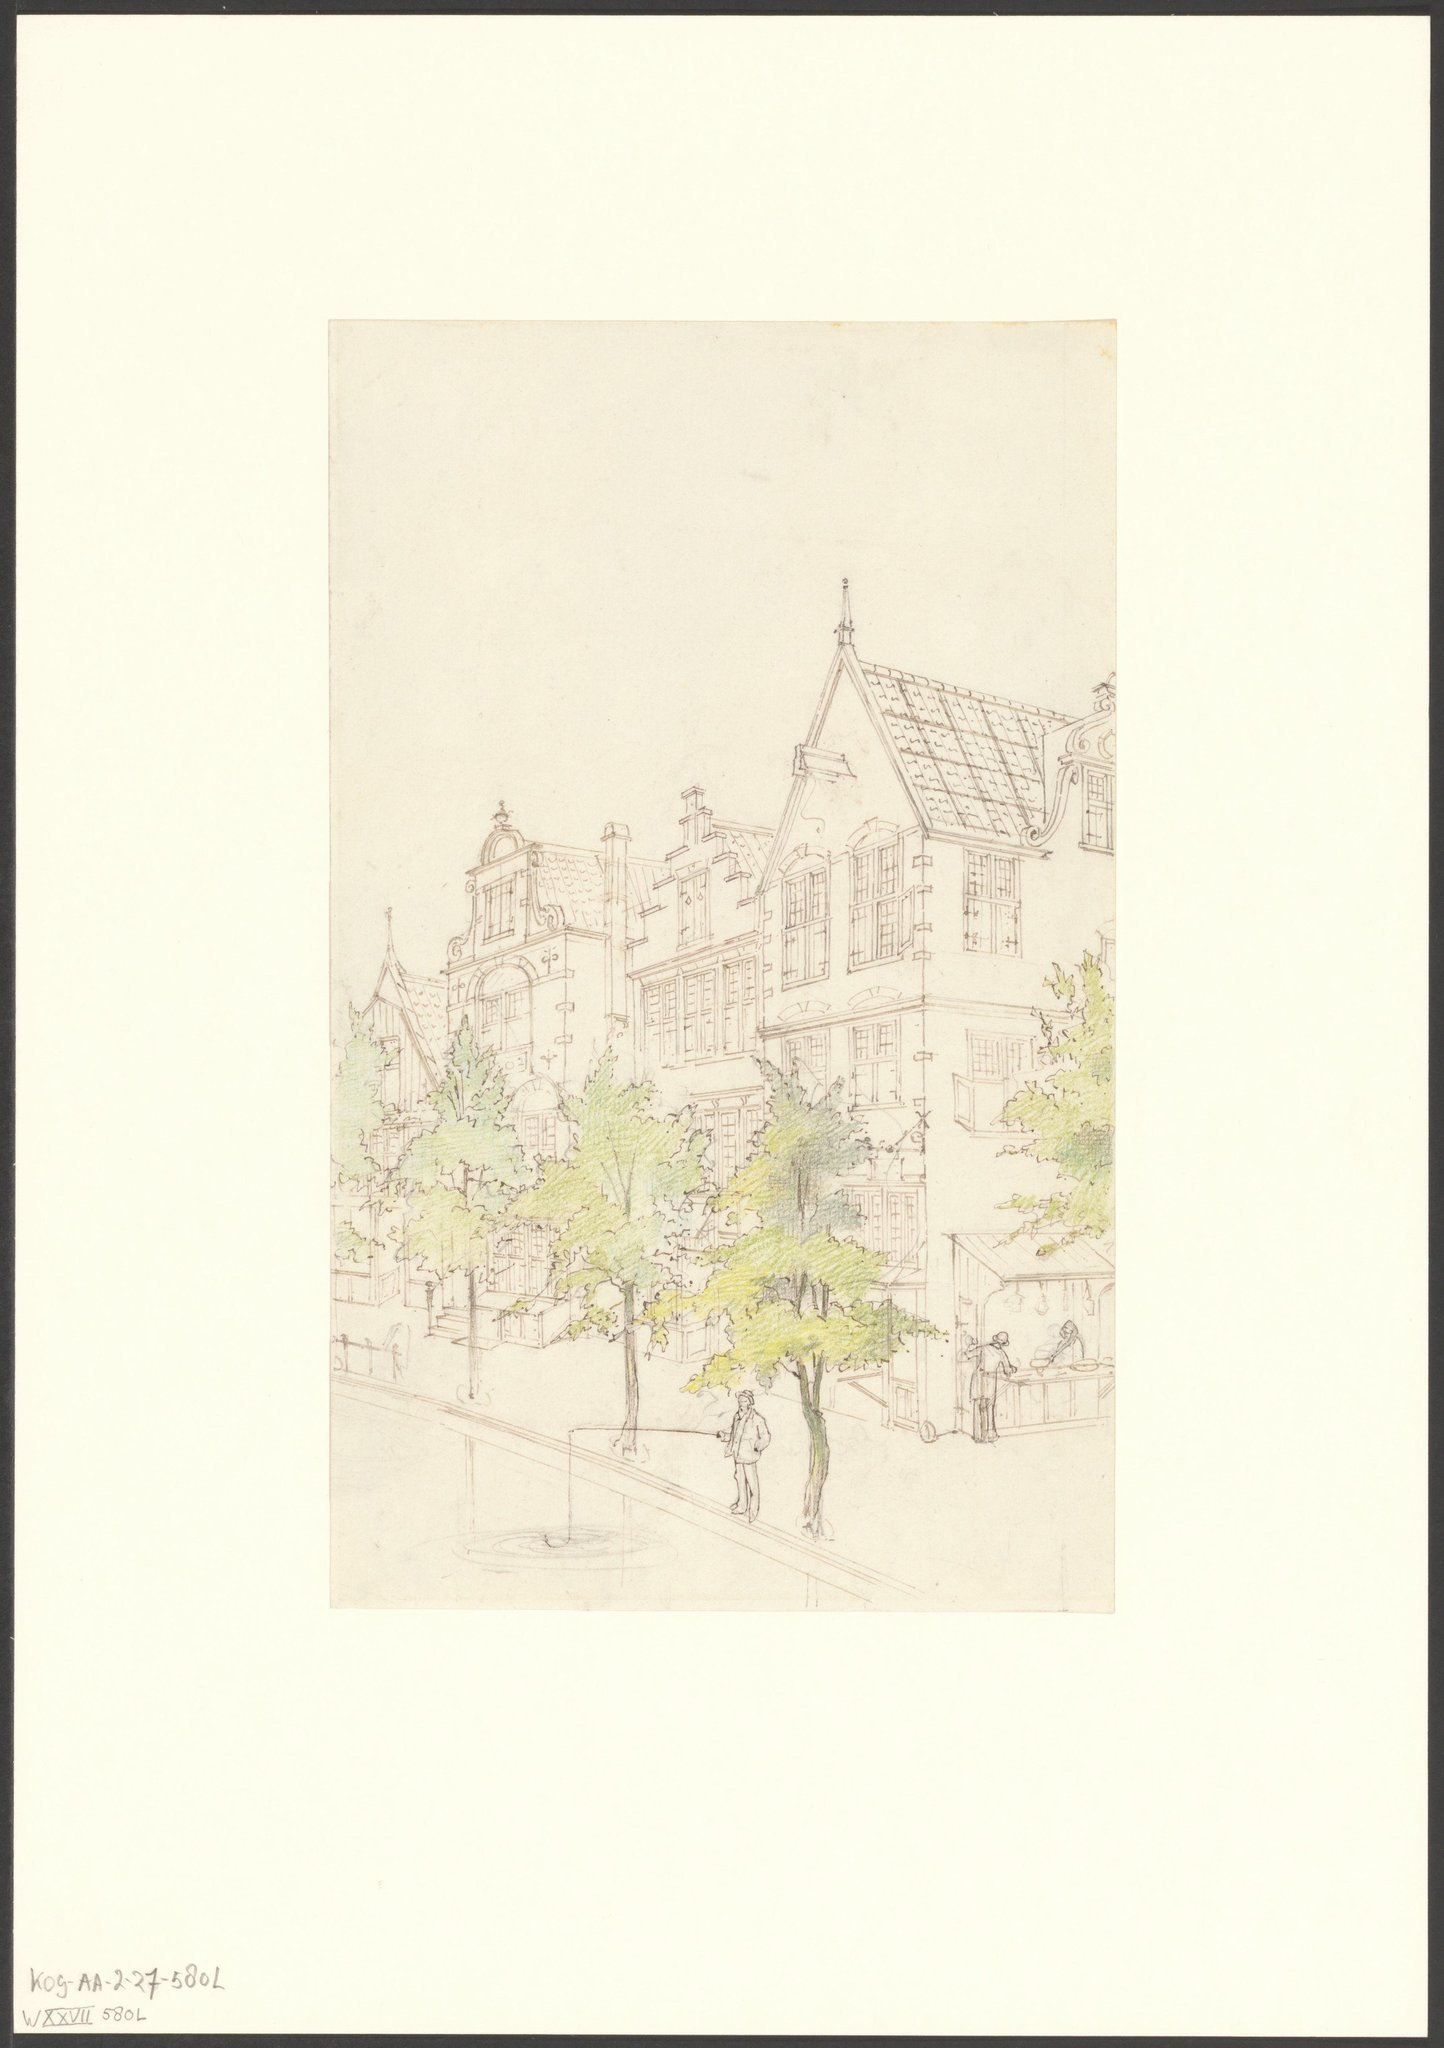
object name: drawing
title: Gezicht op Oud-Holland tijdens de Wereldtentoonstelling voor het Hotel- en Reiswezen in 1895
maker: evert breman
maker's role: architect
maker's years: 1859-1926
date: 1894-1895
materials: ink, paper, pencil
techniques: pen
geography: amsterdam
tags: city-view in general; 'veduta', village street, village, façade (of house or building)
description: Tekening binnen de Atlas Van Eck ingedeeld op wijknummer 27.